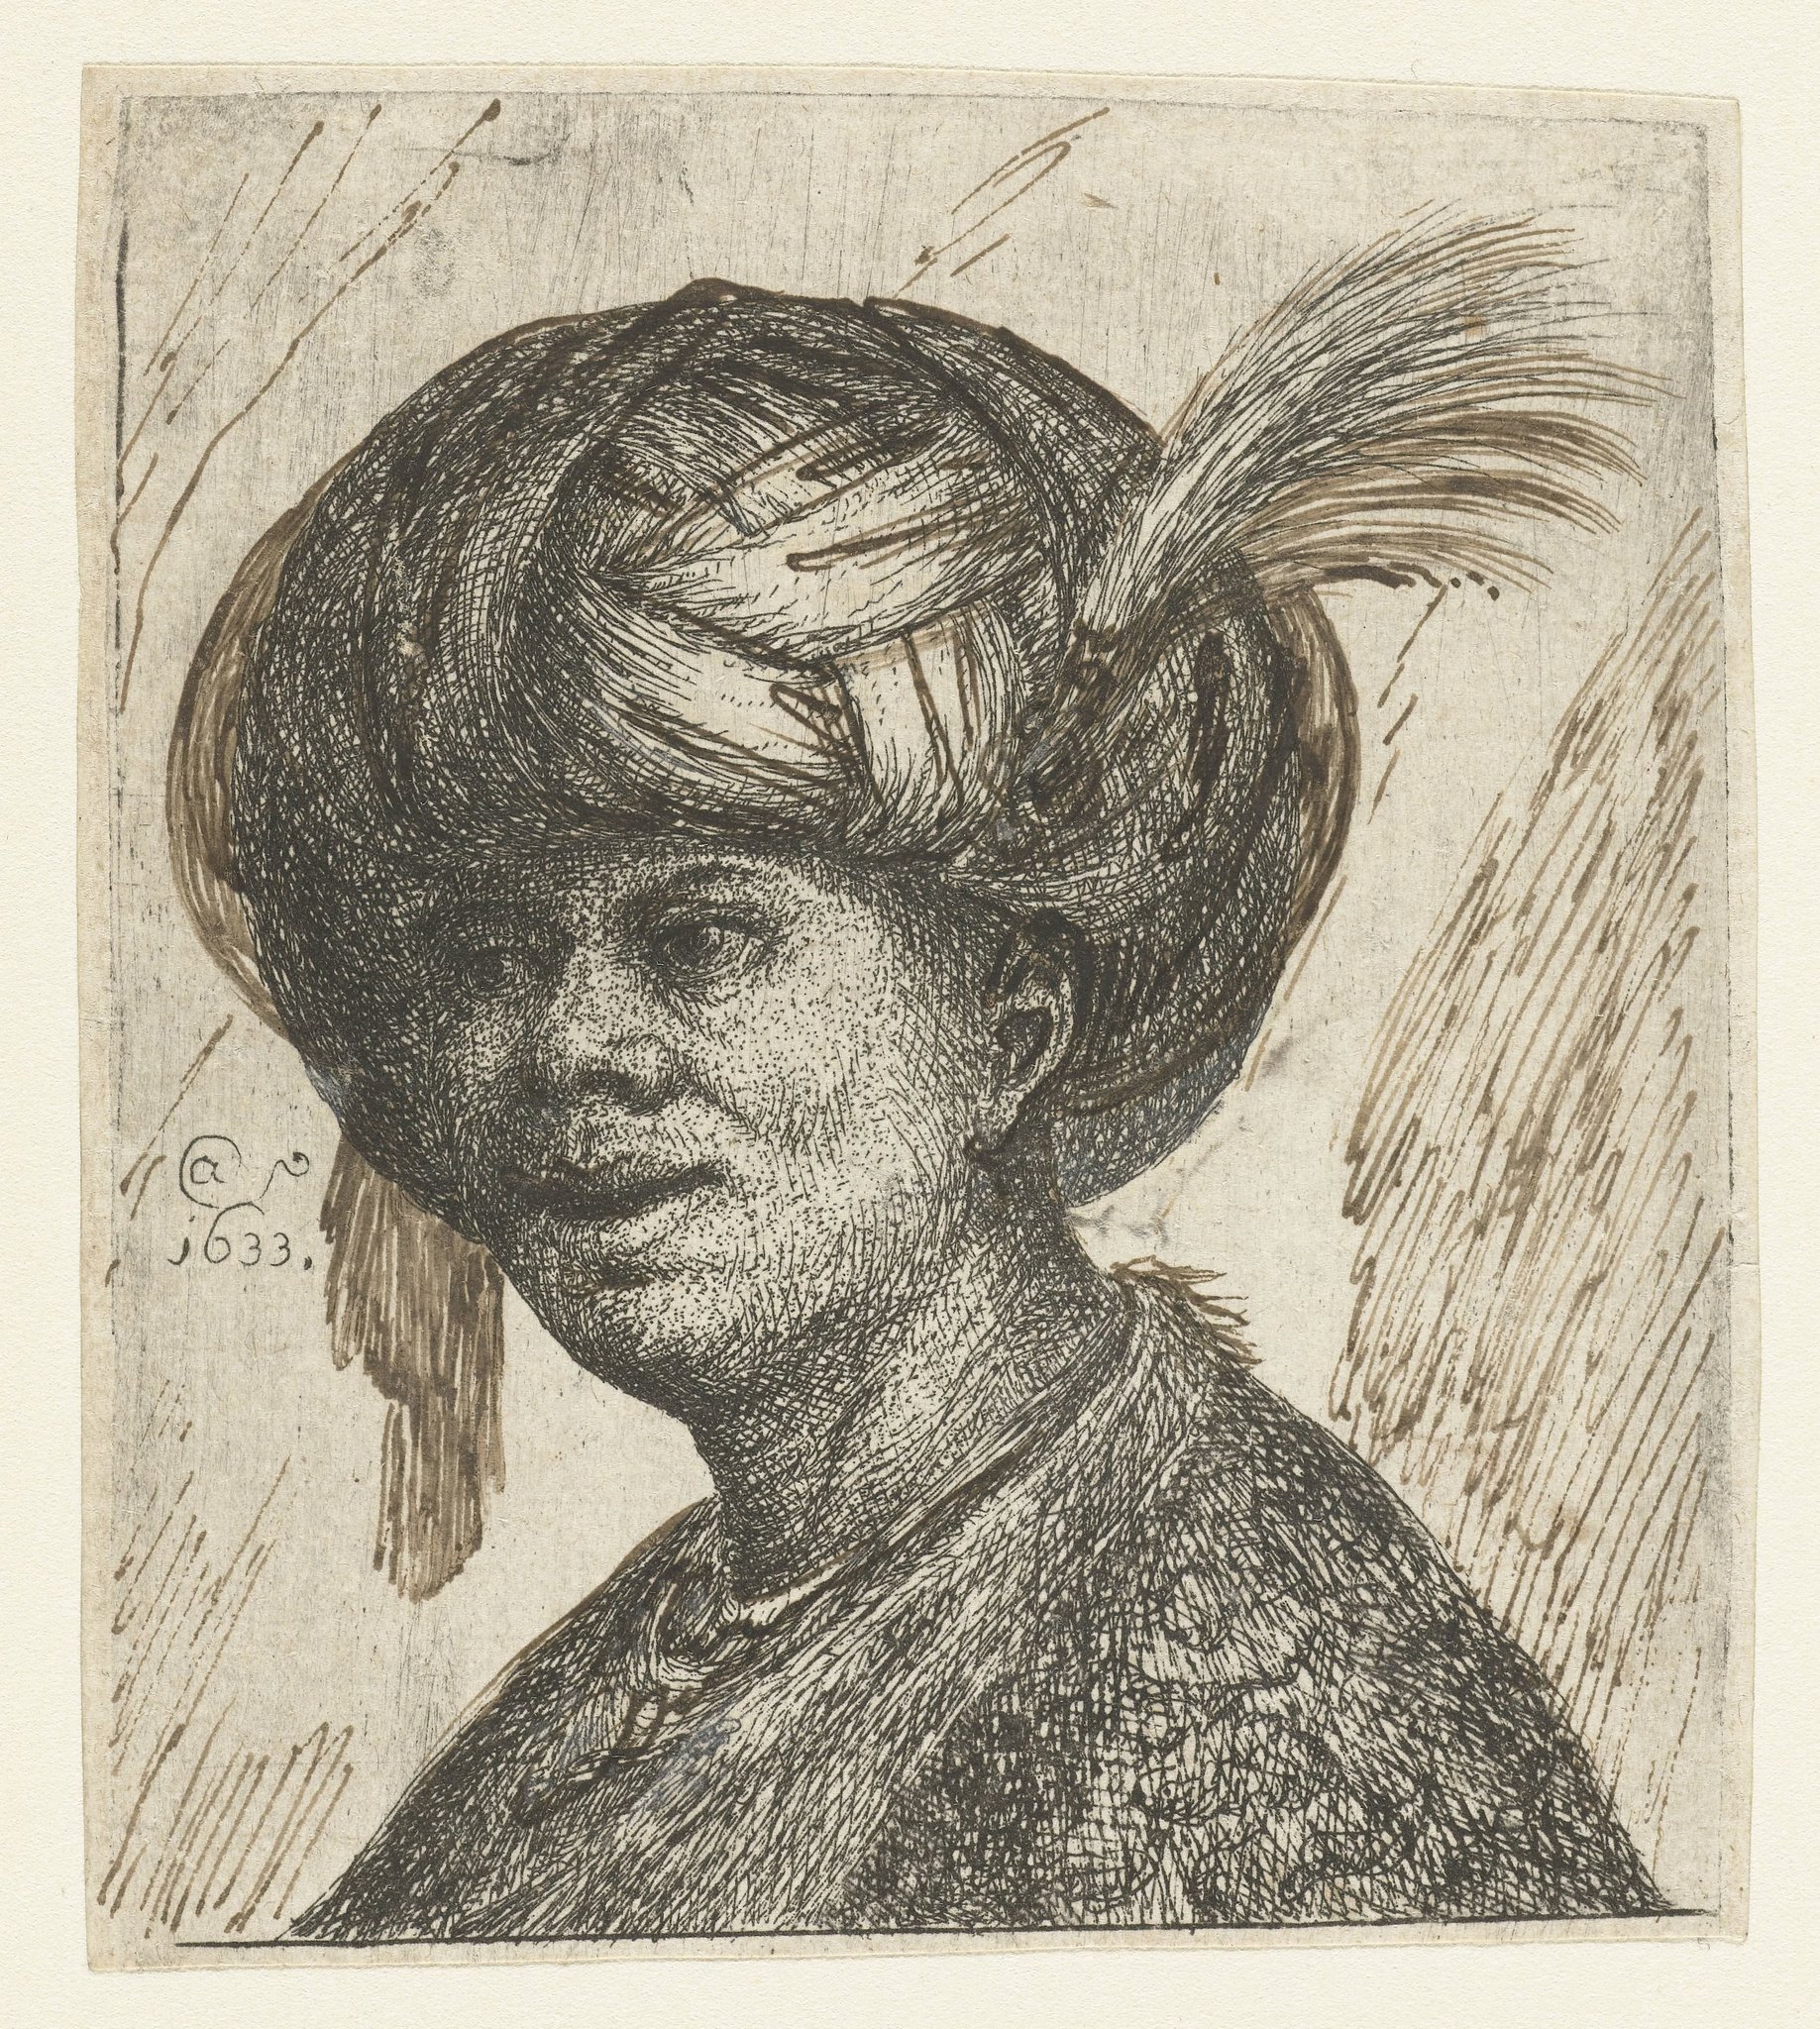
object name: print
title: Buste van een koning met tulband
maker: Anonymous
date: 1633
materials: paper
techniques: etching, pen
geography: netherlands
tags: africans, head-gear: turban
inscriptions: signature: ‘Ca’, collector's mark: Lugt 240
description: Buste van een Afrikaanse koning met een tulband met veer. Met pen is de prent bijgewerkt en is een slip van de tulband getekend.